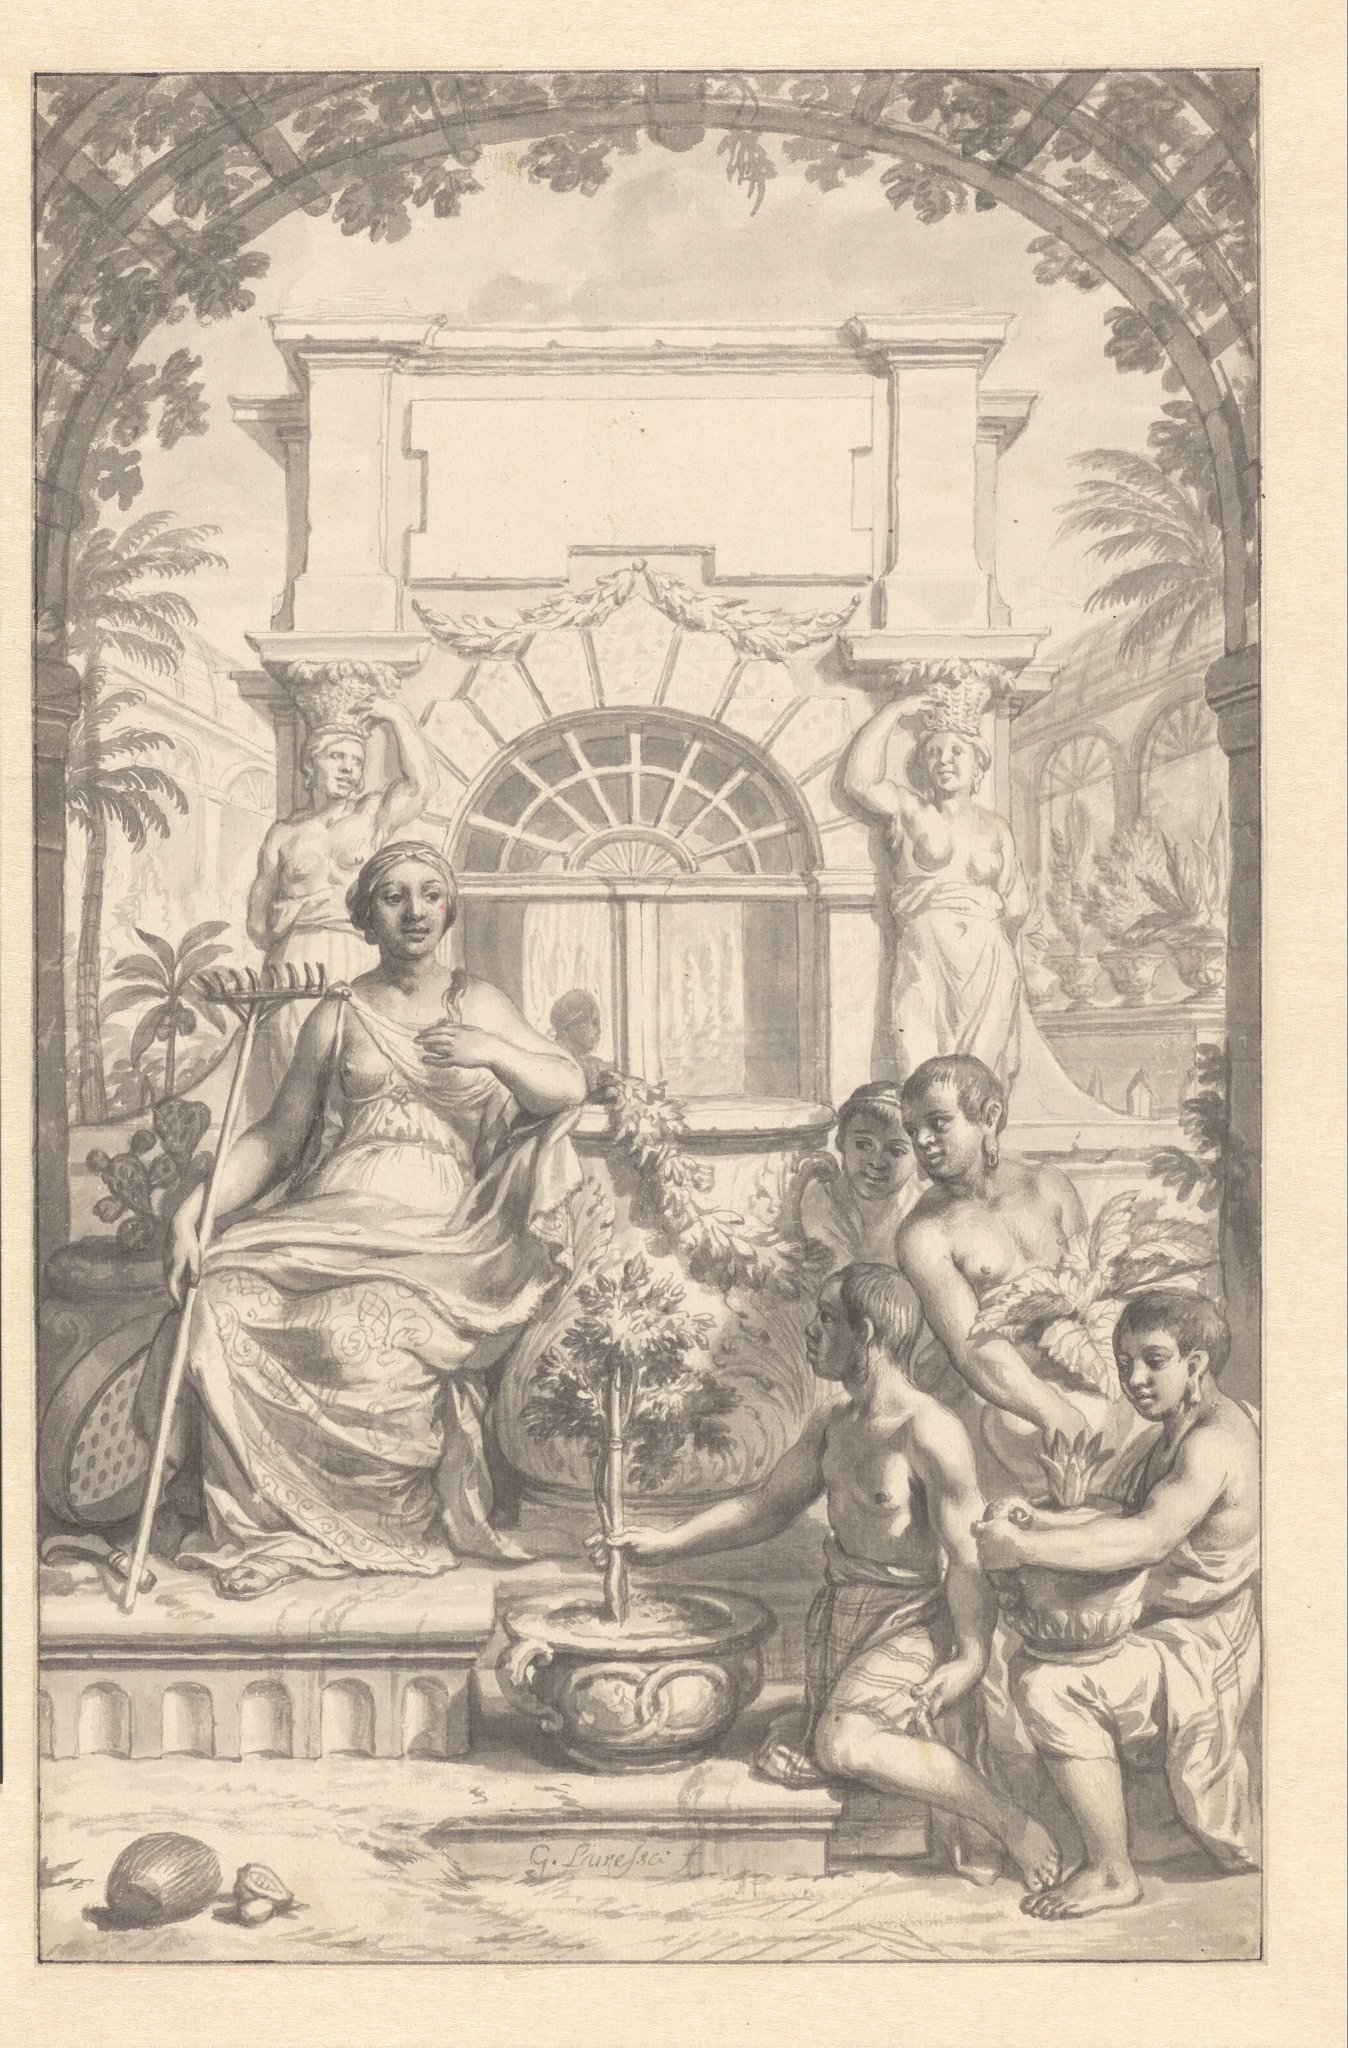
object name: drawing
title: Ontwerp voor titelblad van een boek over tropisch planten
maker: gerard de lairesse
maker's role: draughtsman, painter, print maker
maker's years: 1641-1711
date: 1673-1678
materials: ink, paper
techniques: brush, pen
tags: art, tropical culture, botanic garden, 'hortus botanicus', africans (+ women)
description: Ontwerp voor het titelblad van 'Hortus Indicus Malabaricus', deel III, van H.A. van Rheede tot Draakesteyn.